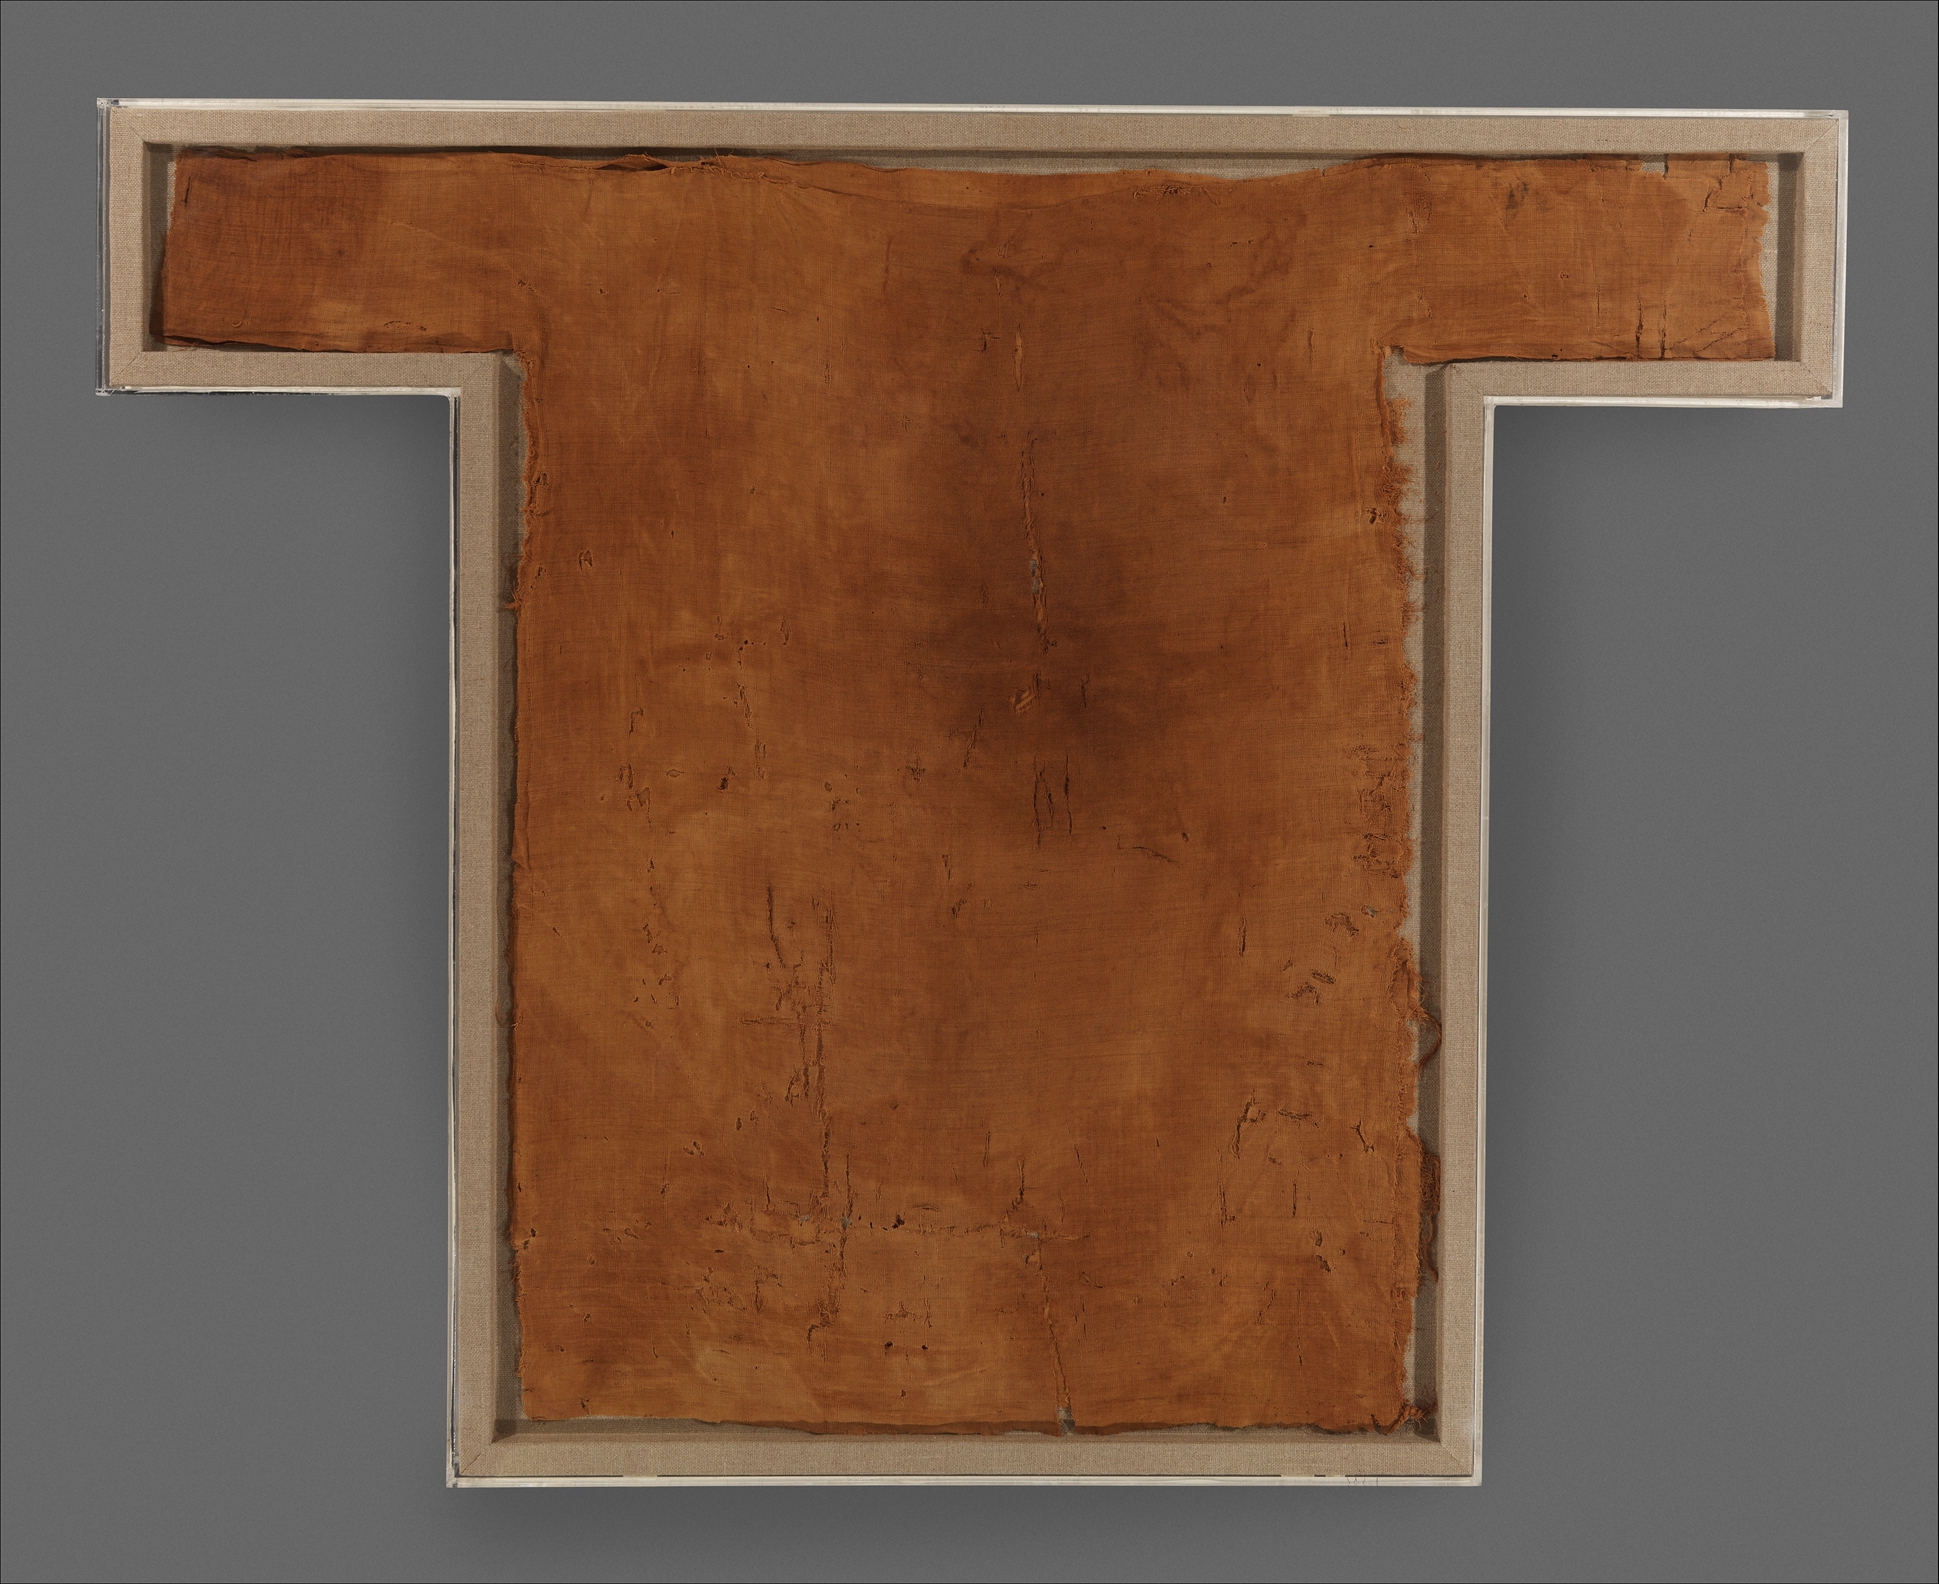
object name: dress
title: Tunic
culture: coptic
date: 301-700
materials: linen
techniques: weave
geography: egypt